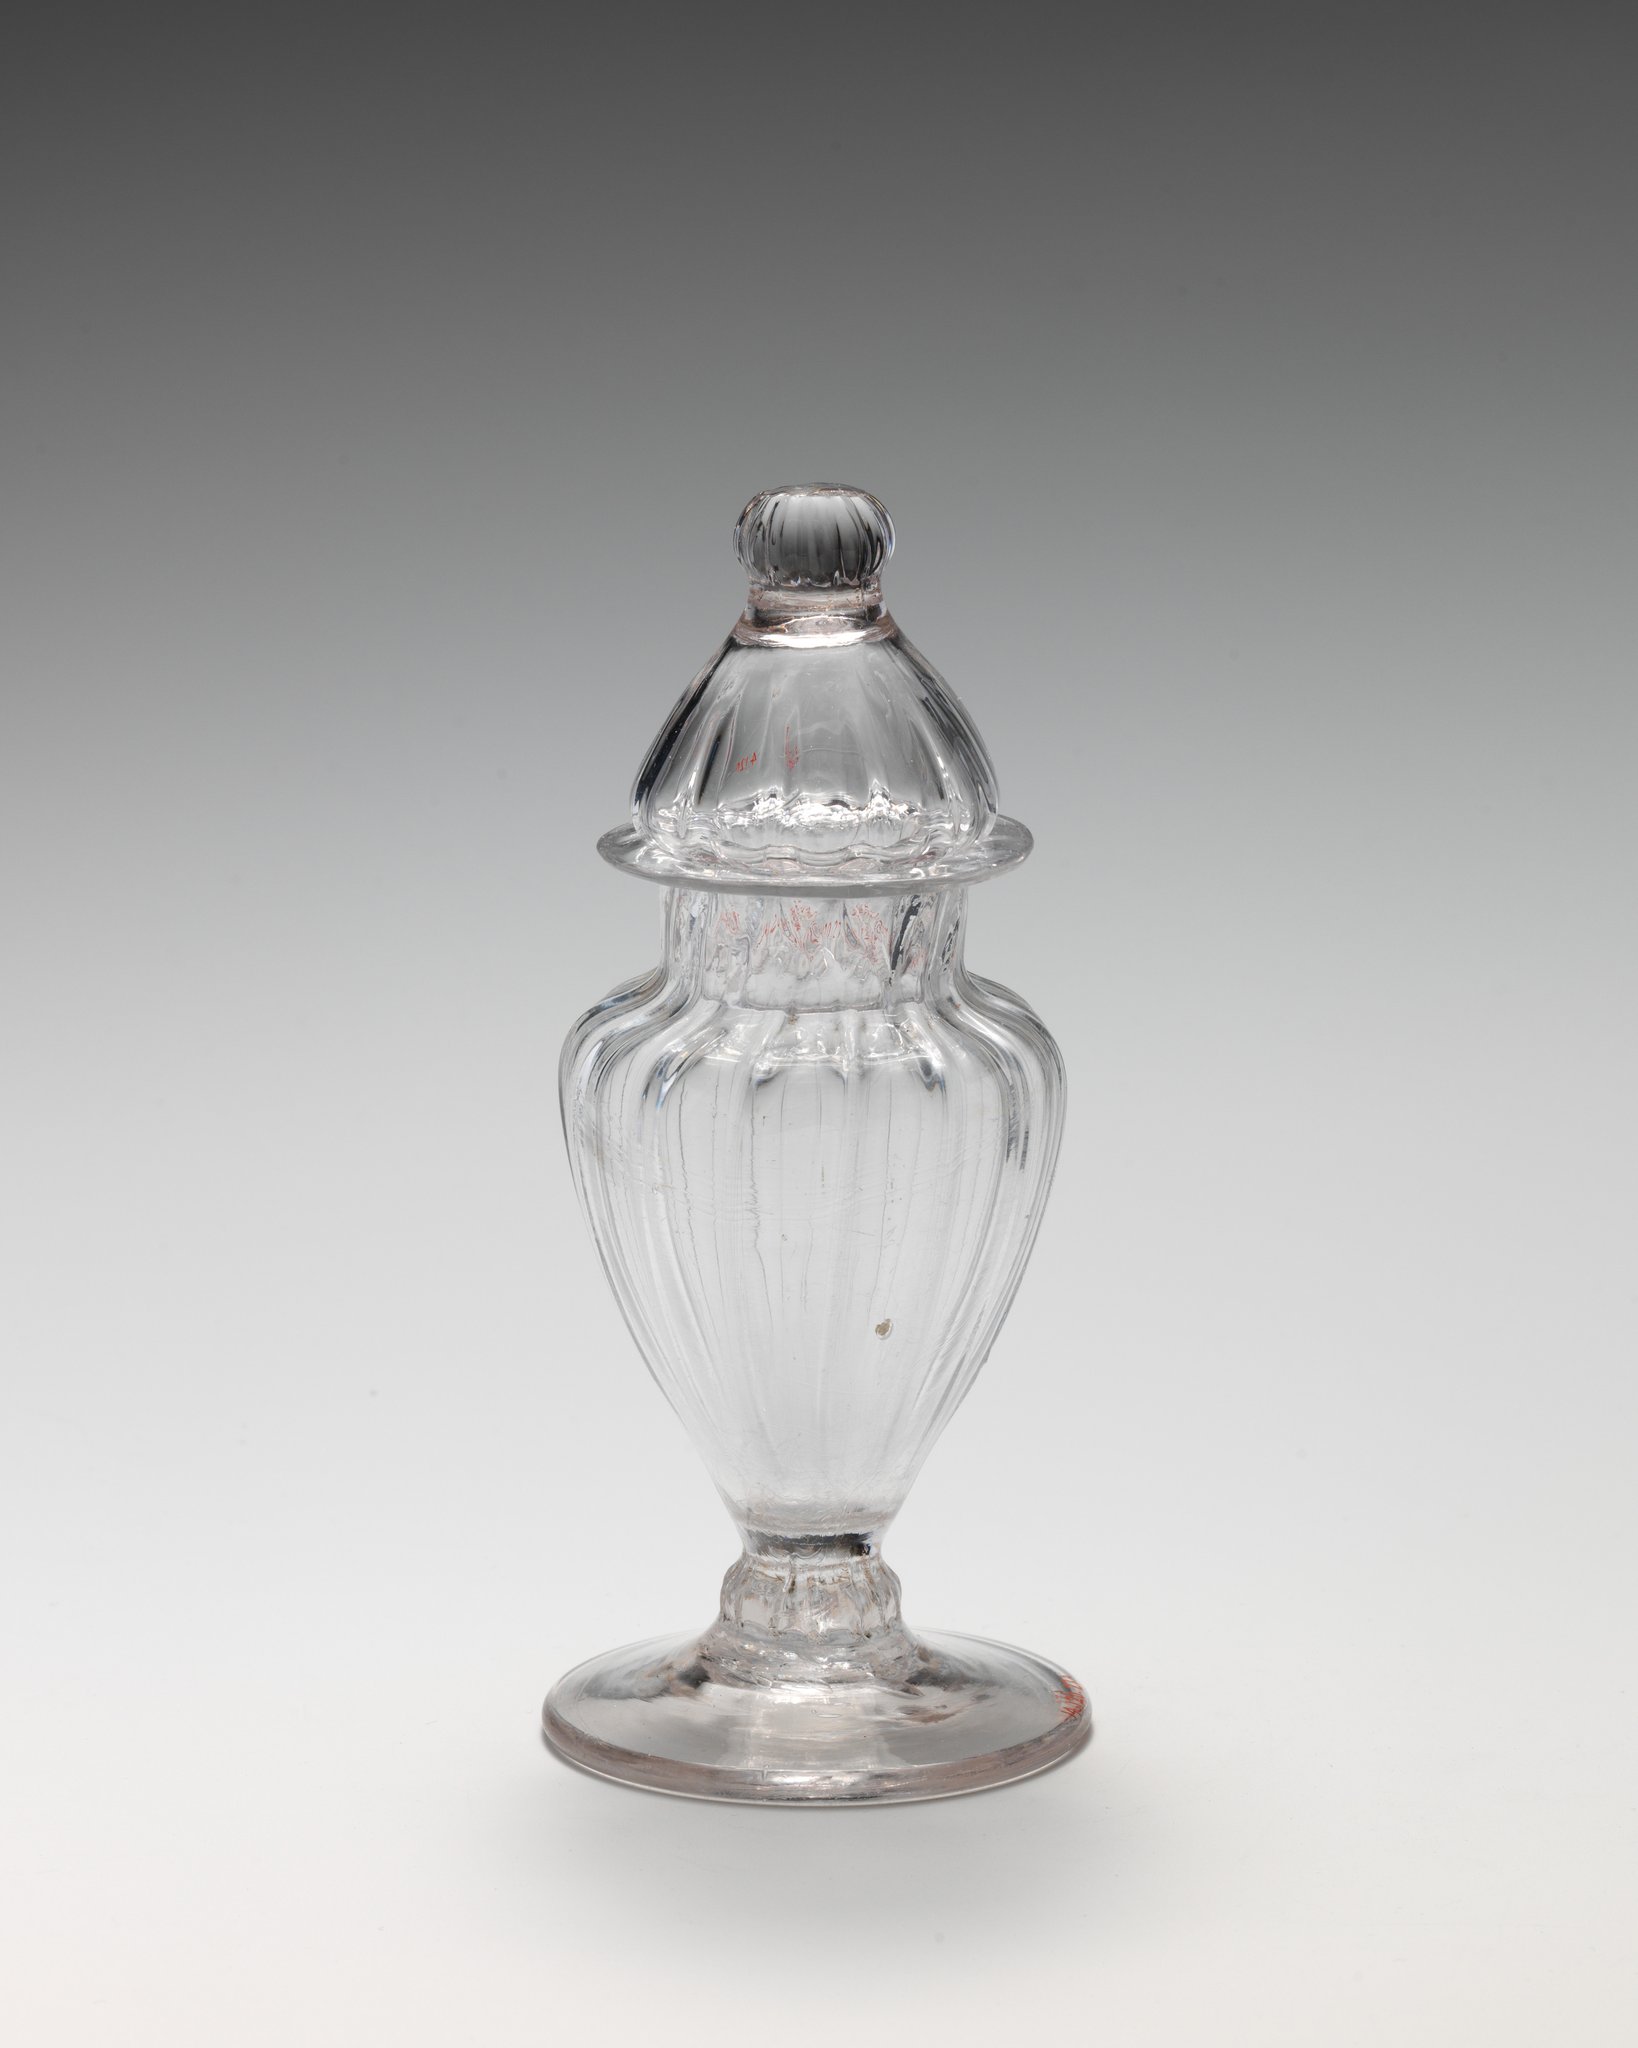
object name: jar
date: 1767-1800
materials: glass